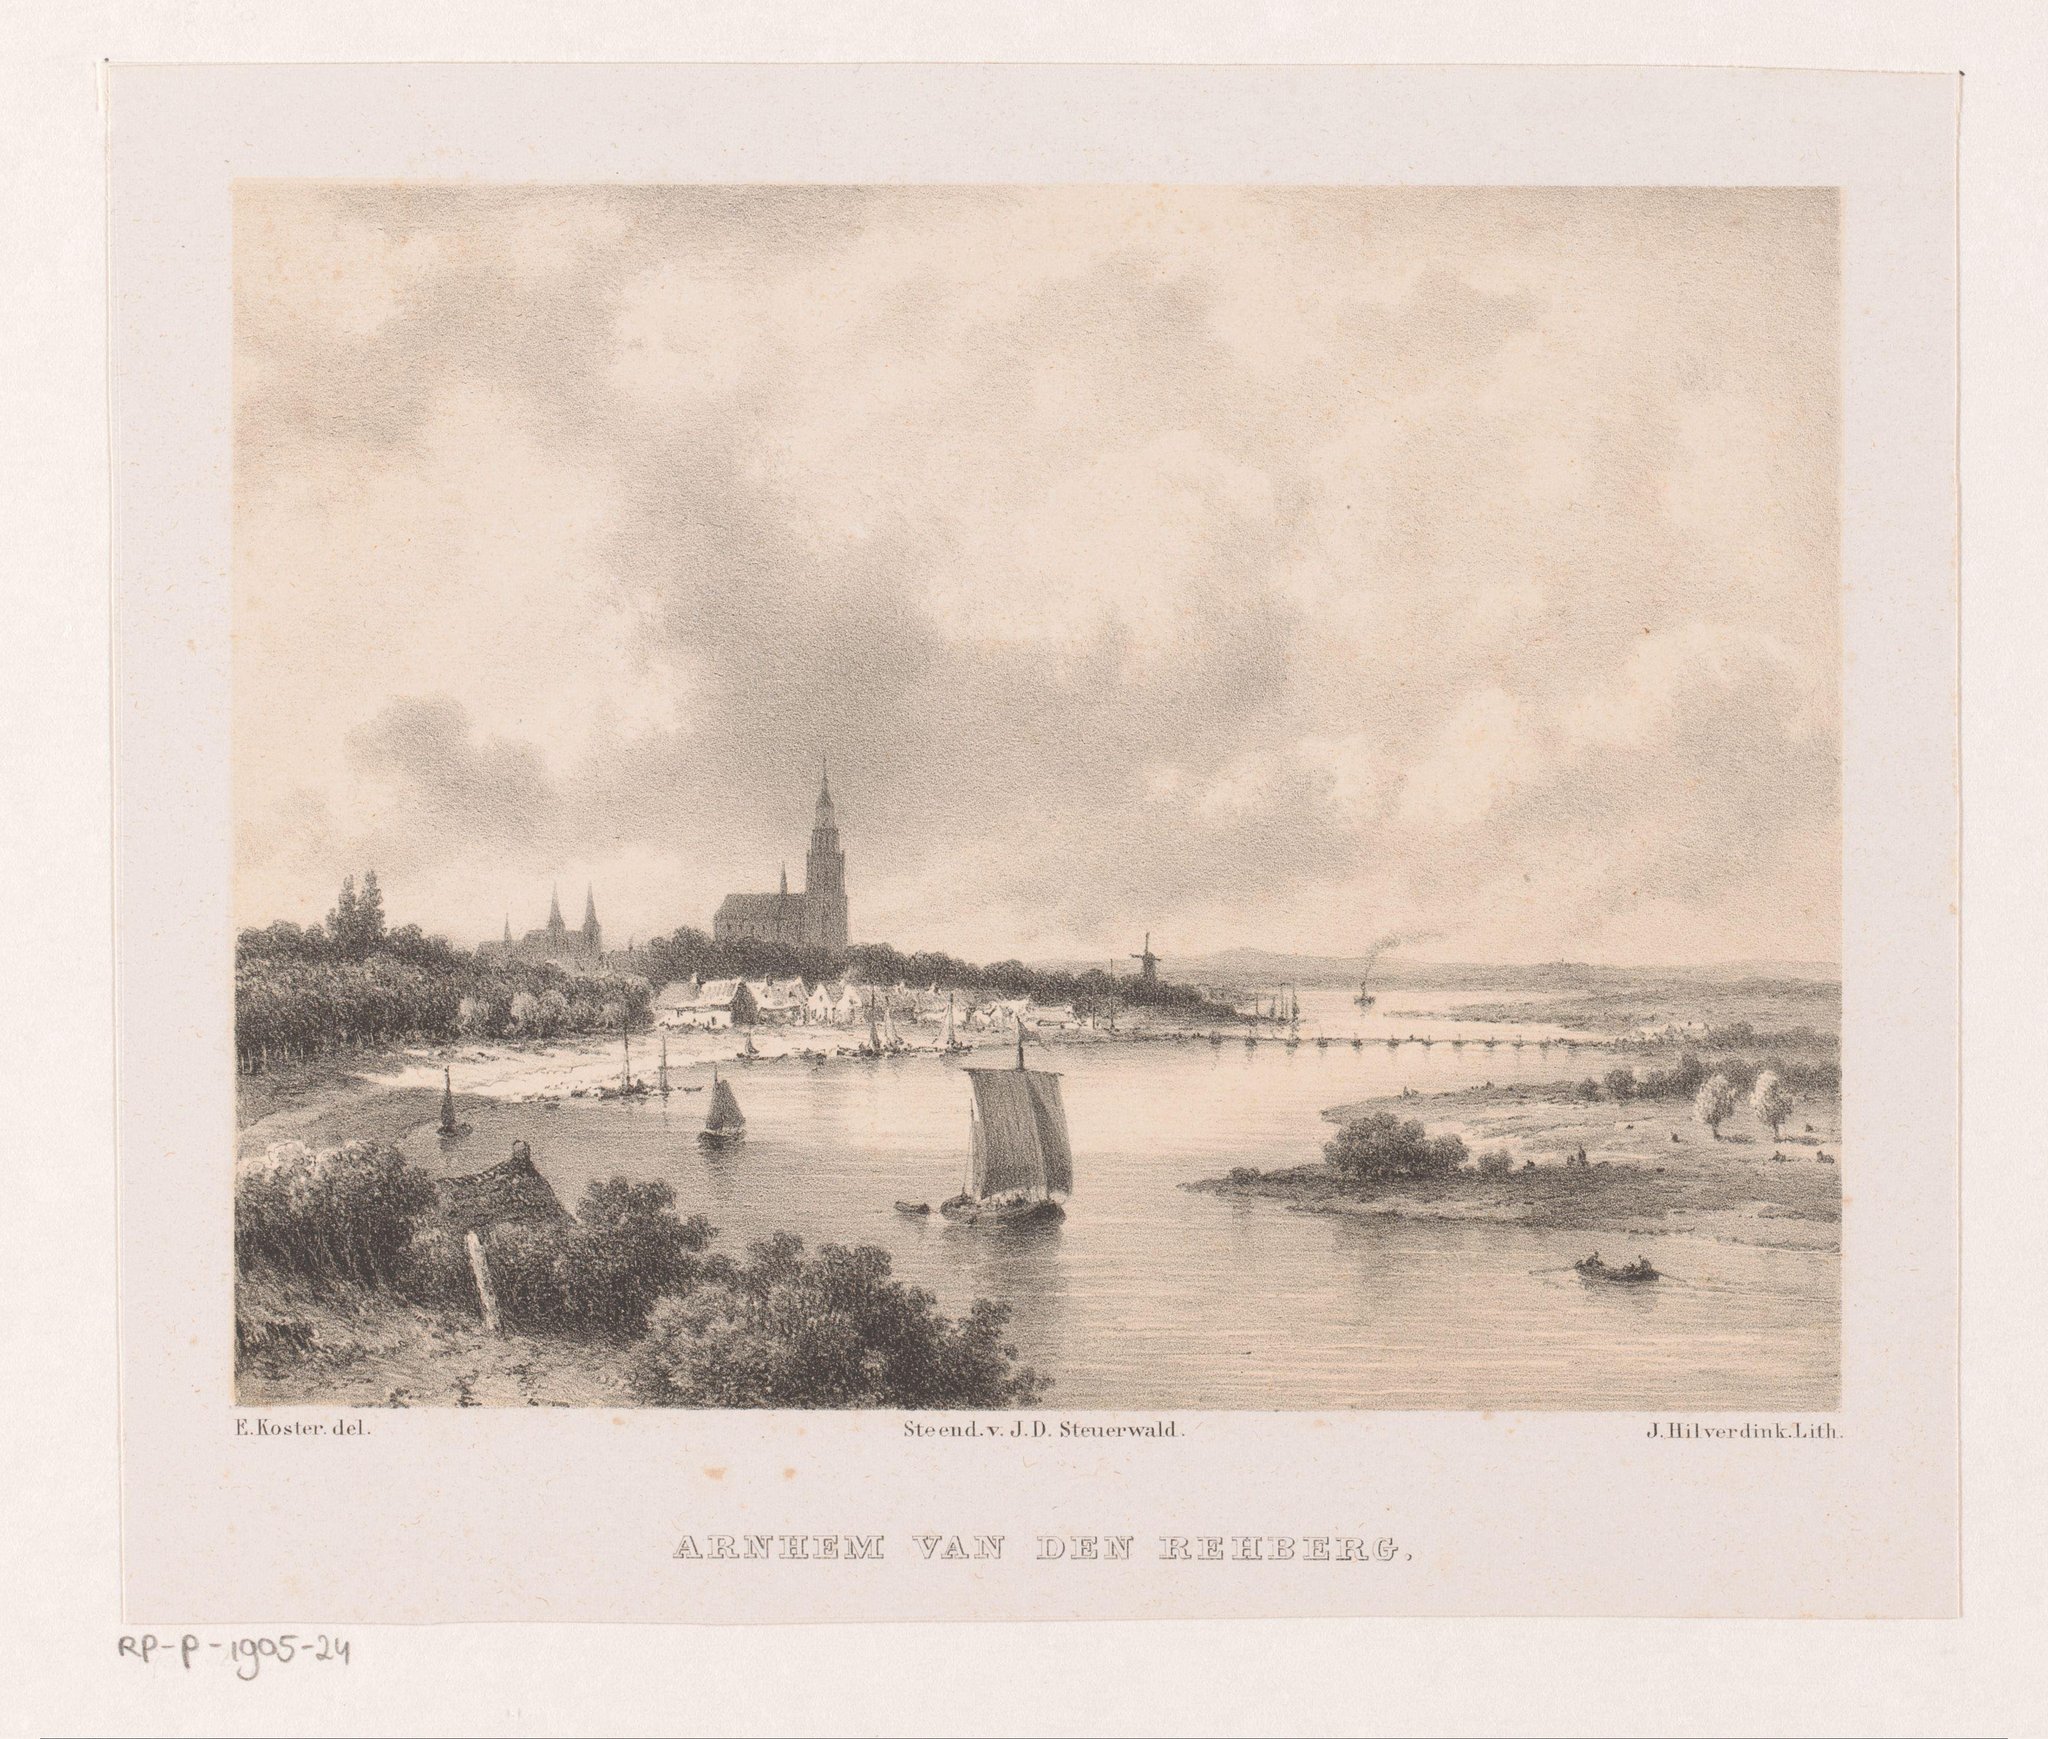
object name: print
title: Arnhem van den Rehberg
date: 1858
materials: paper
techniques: tone lithography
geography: amsterdam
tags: ships (in general), prospect of city, town panorama, silhouette of city, arnhem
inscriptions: collector's mark: Lugt 2228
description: Deze prent komt uit: Koster, E. 'E. Koster's schetsboek: Nederlandsche Stads- en Havengezichten, uitgegeven onder medewerking van de maatschappij Arti et Amicitiae, Amsterdam, F. Buffa en Zn., e.a.' Amsterdam 1858.